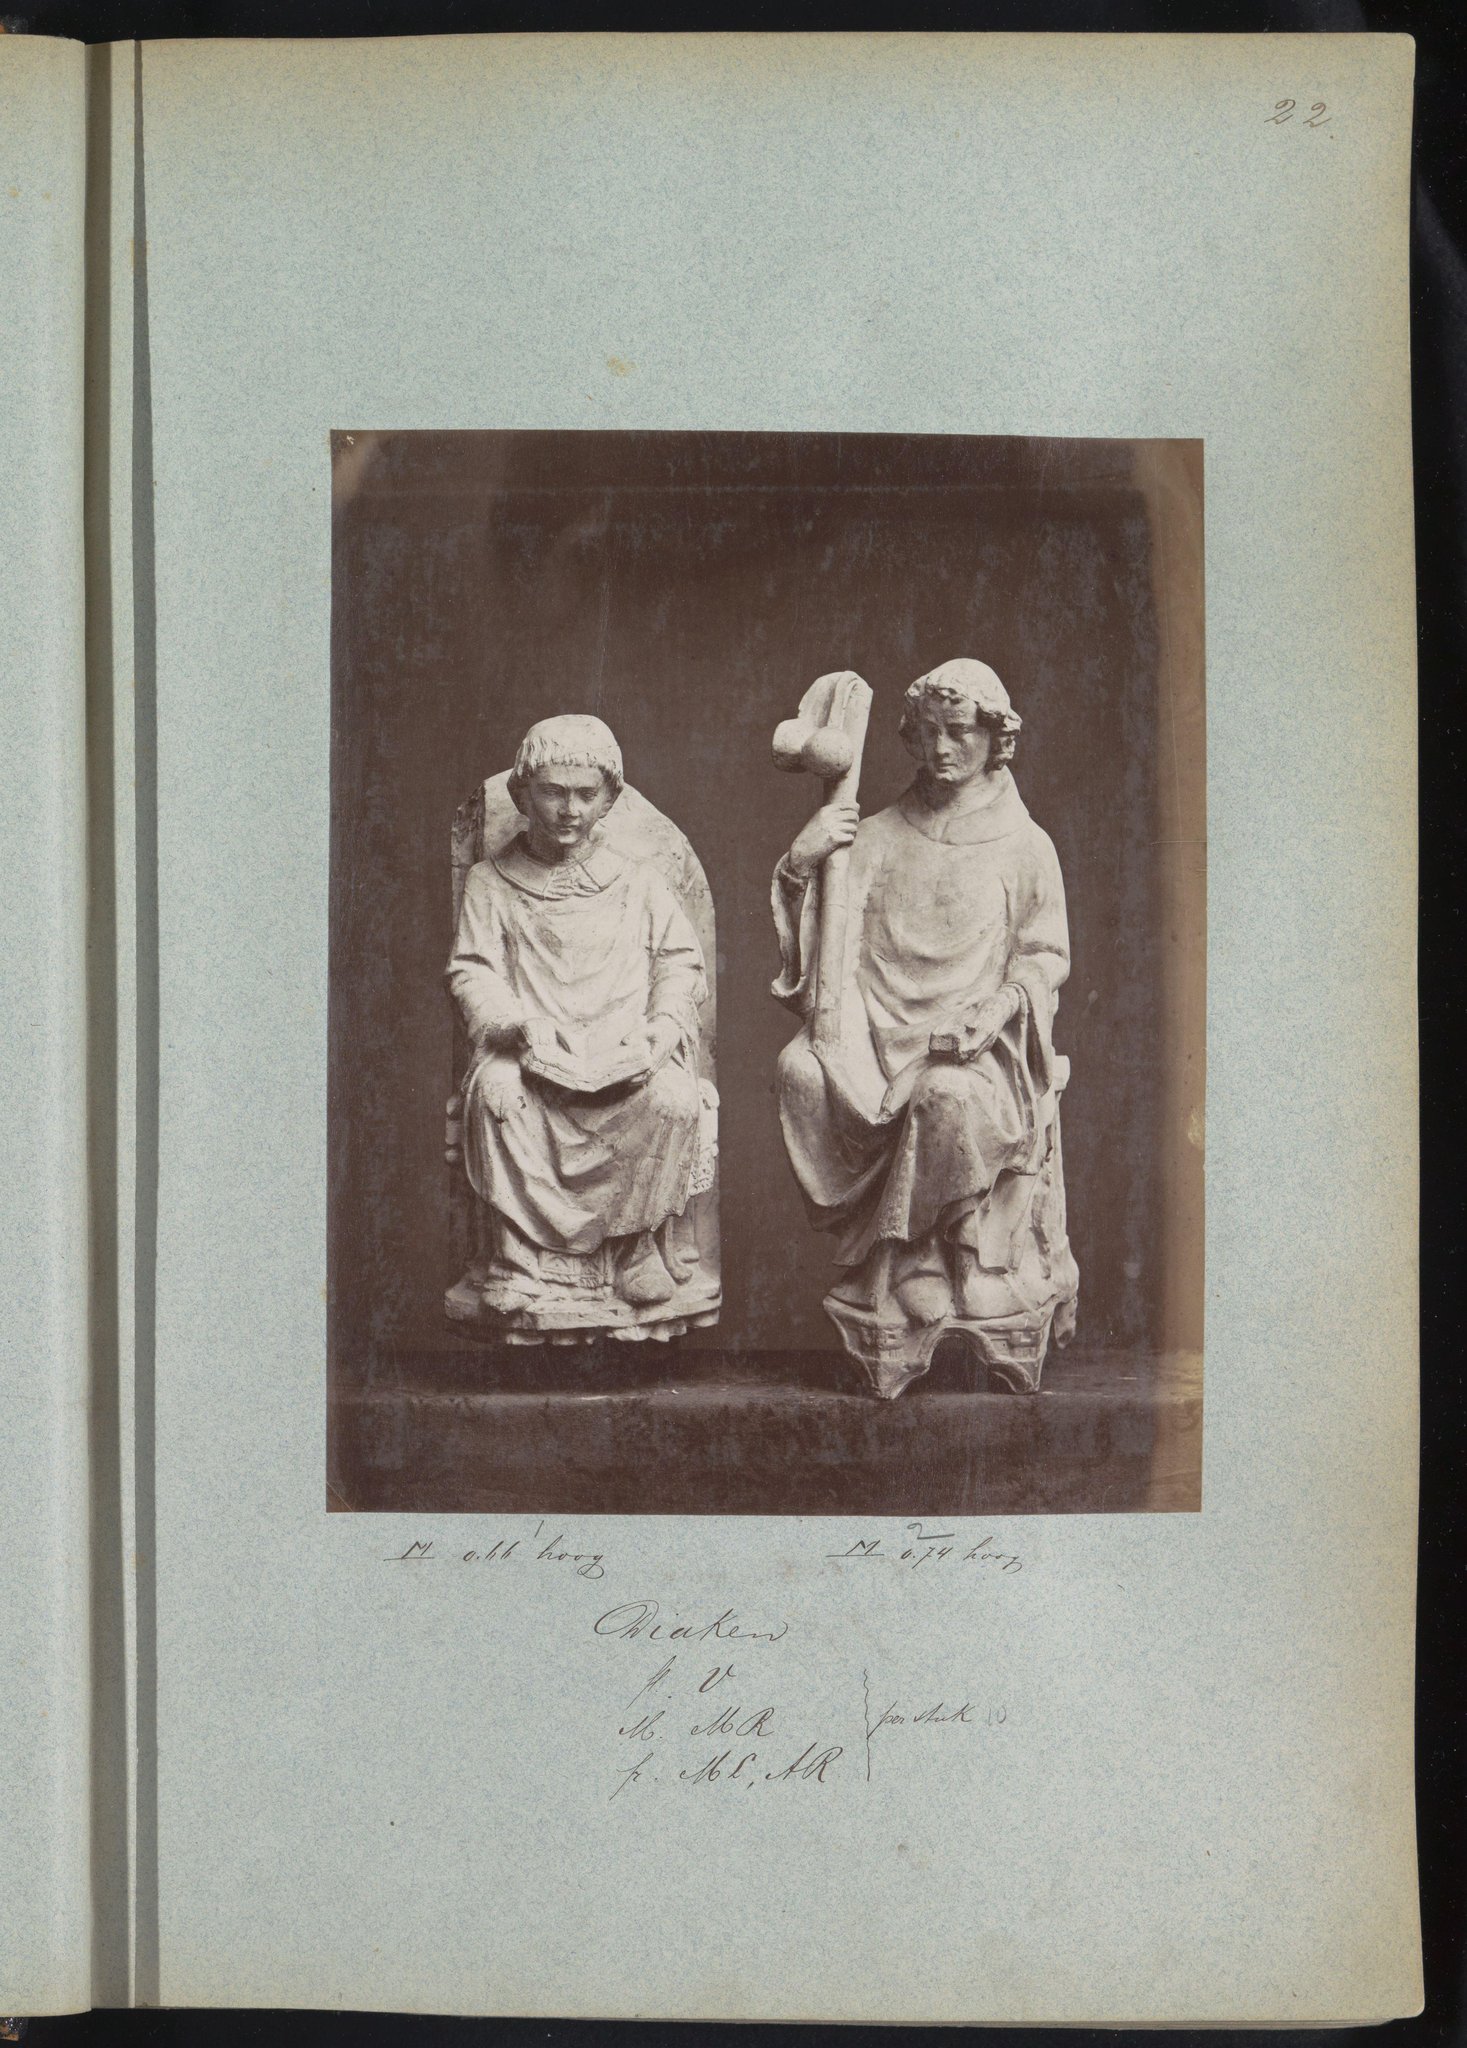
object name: photograph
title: Twee gipsen afgietsels van sculpturen van diaken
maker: Anonymous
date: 1875-1900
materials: paper, photographic support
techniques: albumen print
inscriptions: annotation, annotation: ‘Diaken’, annotation: ‘M 0.66 hoog M 0.74 hoog’